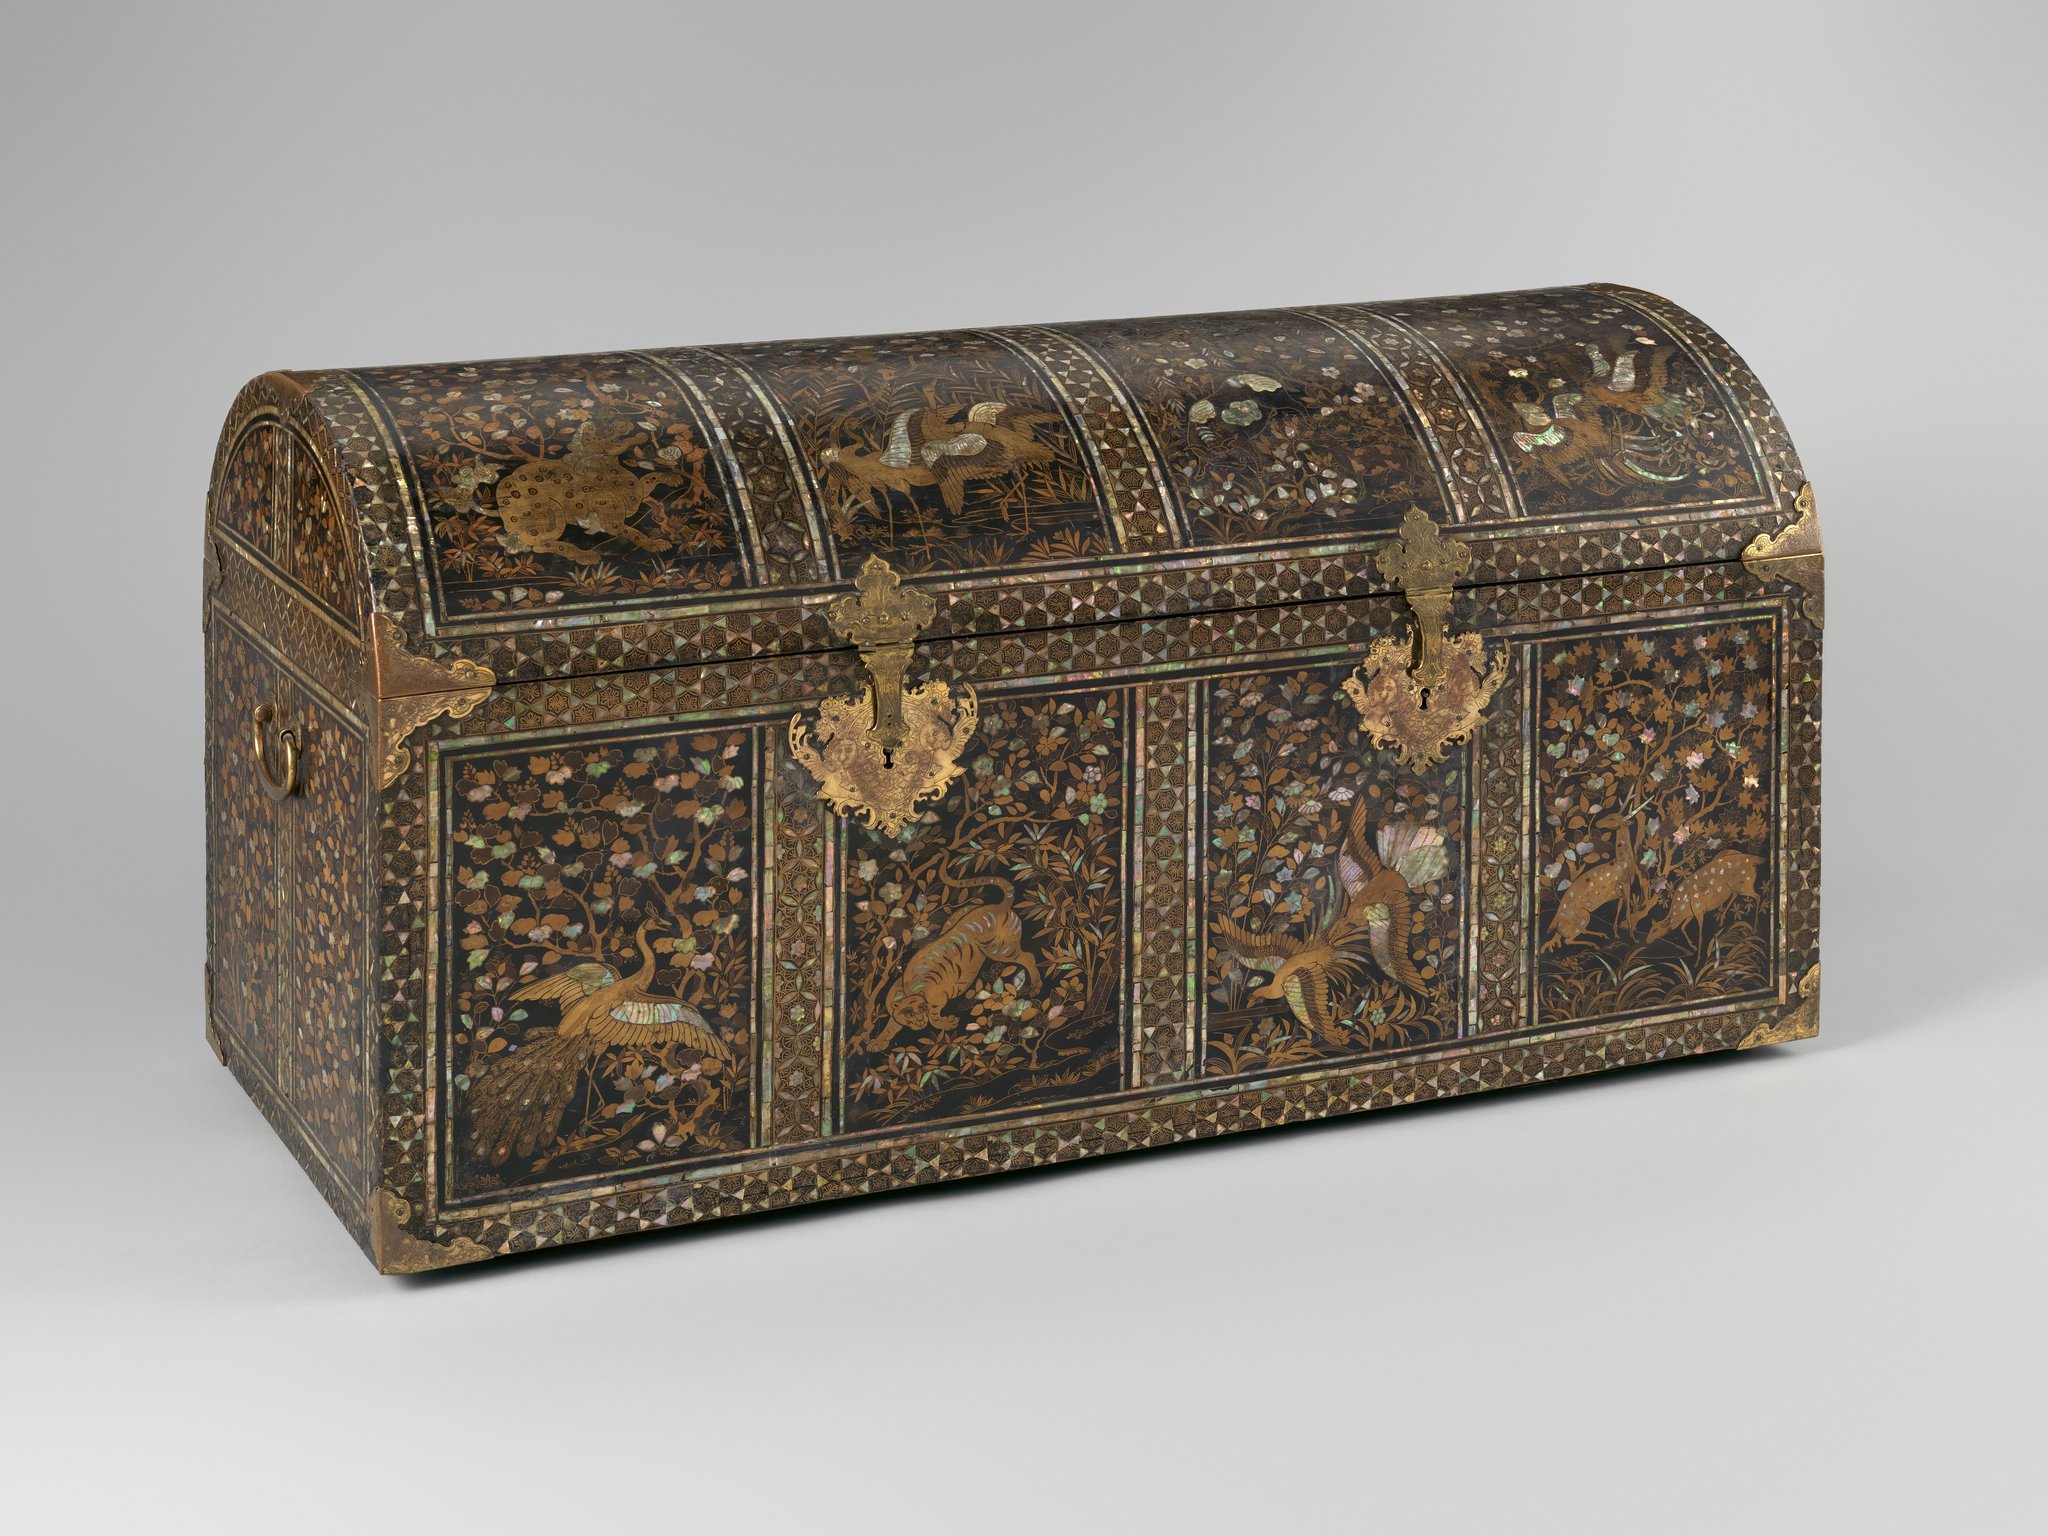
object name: coffer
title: Nanban Coffer with Animals and Landscapes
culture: japanese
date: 1567-1633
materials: gold, mother of pearl, silver, wood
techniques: hiramakie, inlay, lacquer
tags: birds,peacocks,deer,tigers,chests